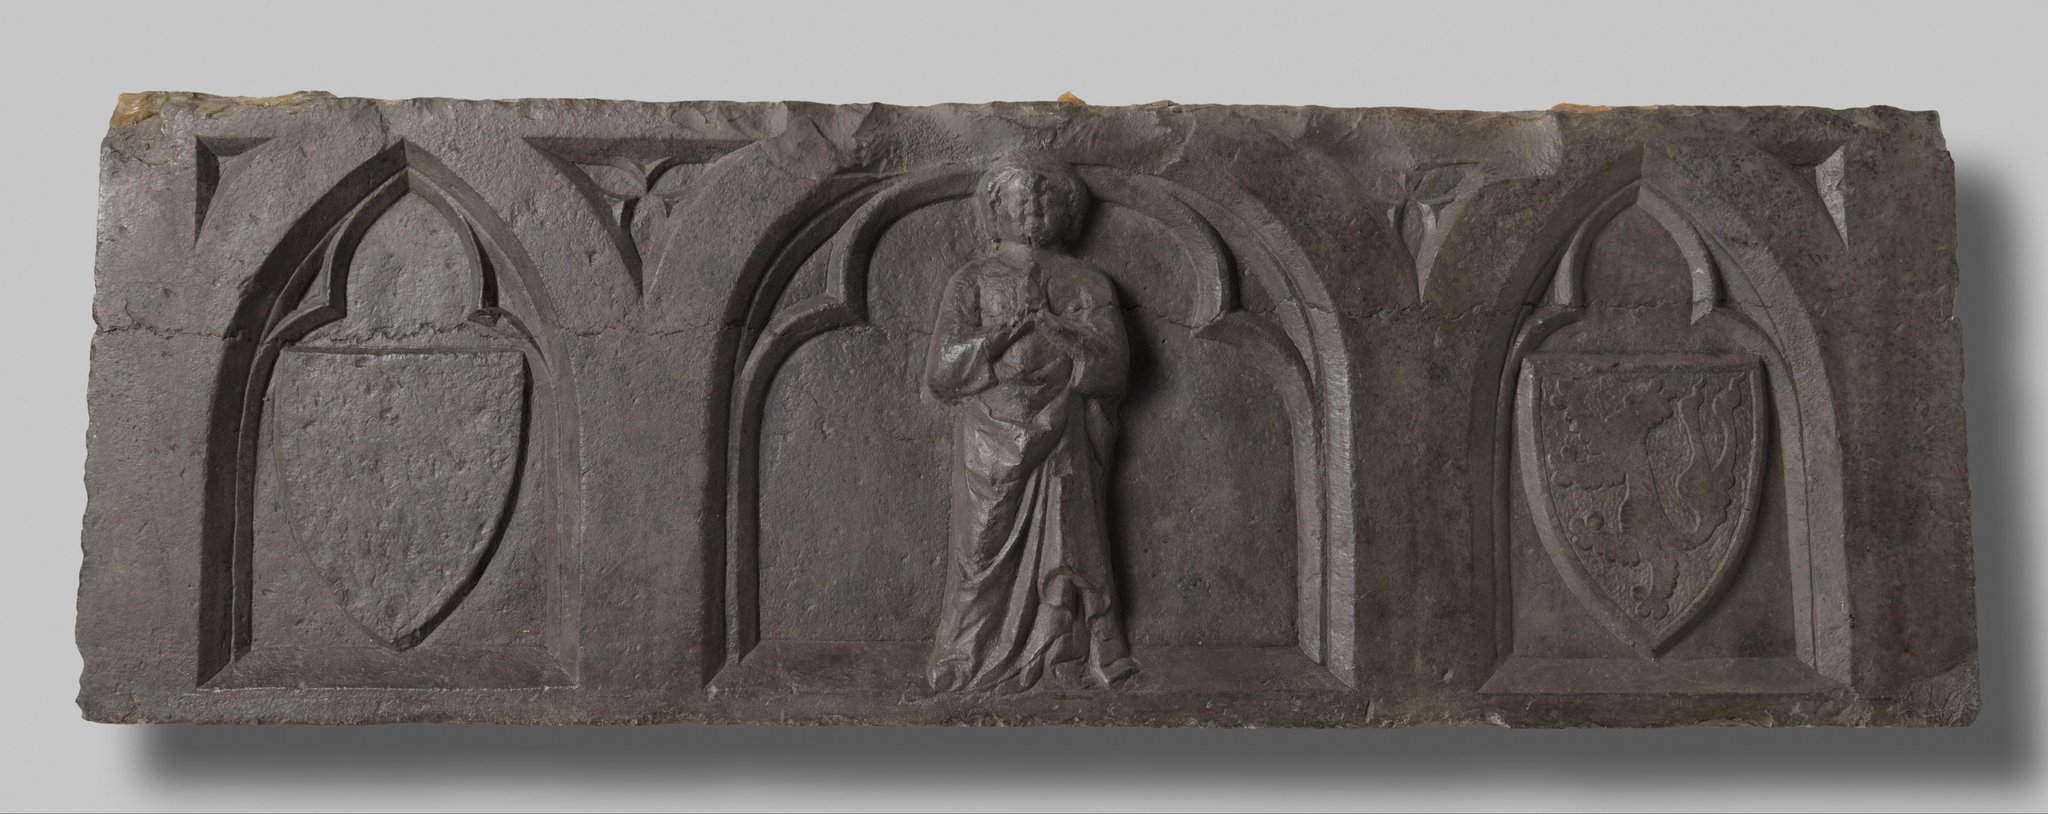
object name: tomb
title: Tomb of Arnold van der Sluis of Heusden, Knight (c. 1245-1296)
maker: Anonymous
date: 1296-1325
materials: limestone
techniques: carved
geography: meuse area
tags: bern (gelderland)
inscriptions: coat of arms, inscription: ‘[Qui fuerat gratus cun]ctis iac[et] h[ic] tumulat[us] Husde[n]si nat[us] ex clara stirpe vocat[us] Arnold[us] mile[s] de slusa sp[er]ne[re] viles Act[us] h[ic] novit falso[s] [a] seque removit Fortis formosus prudens erat atque animosus Justus pacifuc probitati semper amicus Finiit is vitam morum gravitate p]olita[m] Q[ua]rto redde[n]das a mense dec[em]bre kale[n]das. An[n]o milleno d[omi]ni noviesq[ue] noveno Et bis centeno terno quo[que] cu[m] duedeno Gaudeat in c[oelis ut hoc orat] quis[que] fidelis Hoc pater et flamen sacrum nat[us]q[ue] [det amen]’, coat of arms, in reliëf, coat of arms, in relief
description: Onderdeel van de graftombe van Ridder Arnold van der Sluis van Heusden. In het onderdeel staat een heilige geflankeerd met twee wapenschilden.